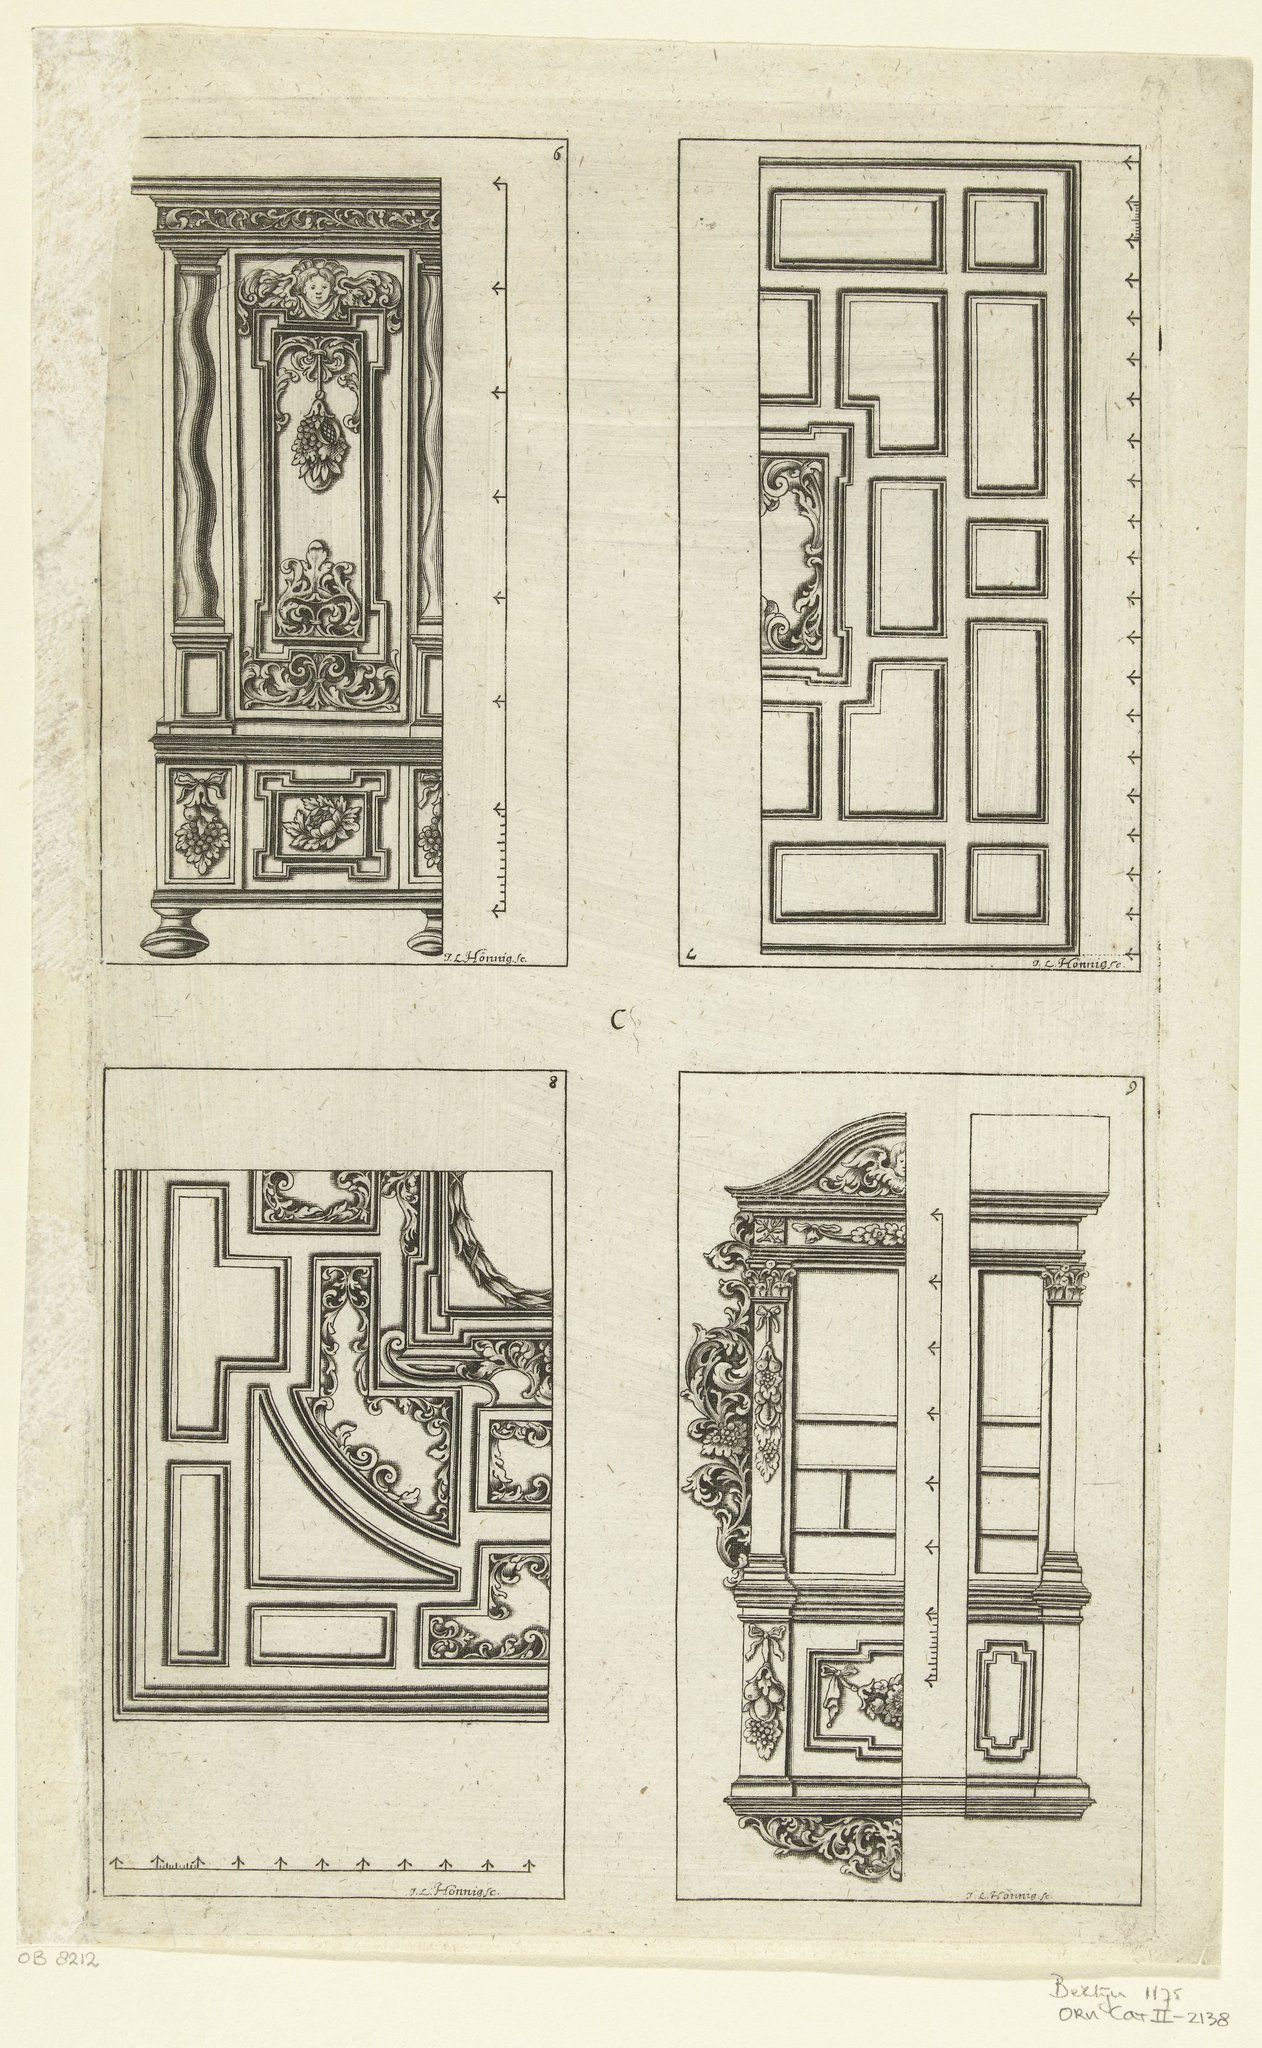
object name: print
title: Neues Zierahten Büchlein von allerhand Schreinwerck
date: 1695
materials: paper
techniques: engraving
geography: nuremberg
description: Nummer 6 t/m 9. Nummer 6 laat een kast zien met een paneel tussen gebogen zuilen, op de nummers 7 en 8 staan plafonds, op nummer 9 is de linkerhelft van een kledingkast te zien, van voren en opzij.